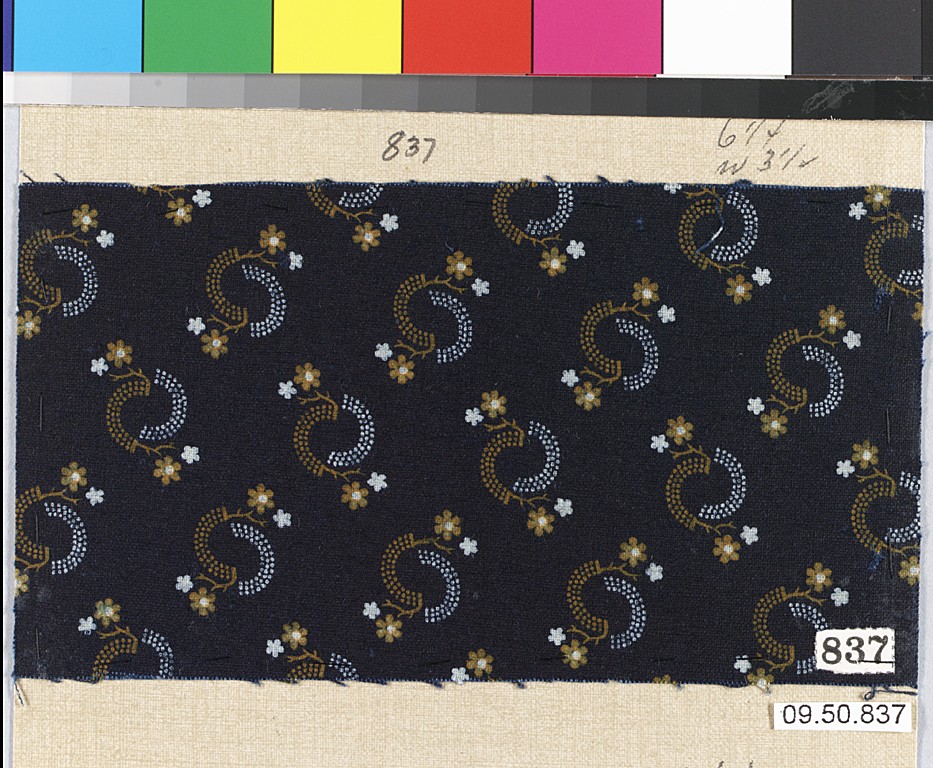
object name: piece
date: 1801-1900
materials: cotton